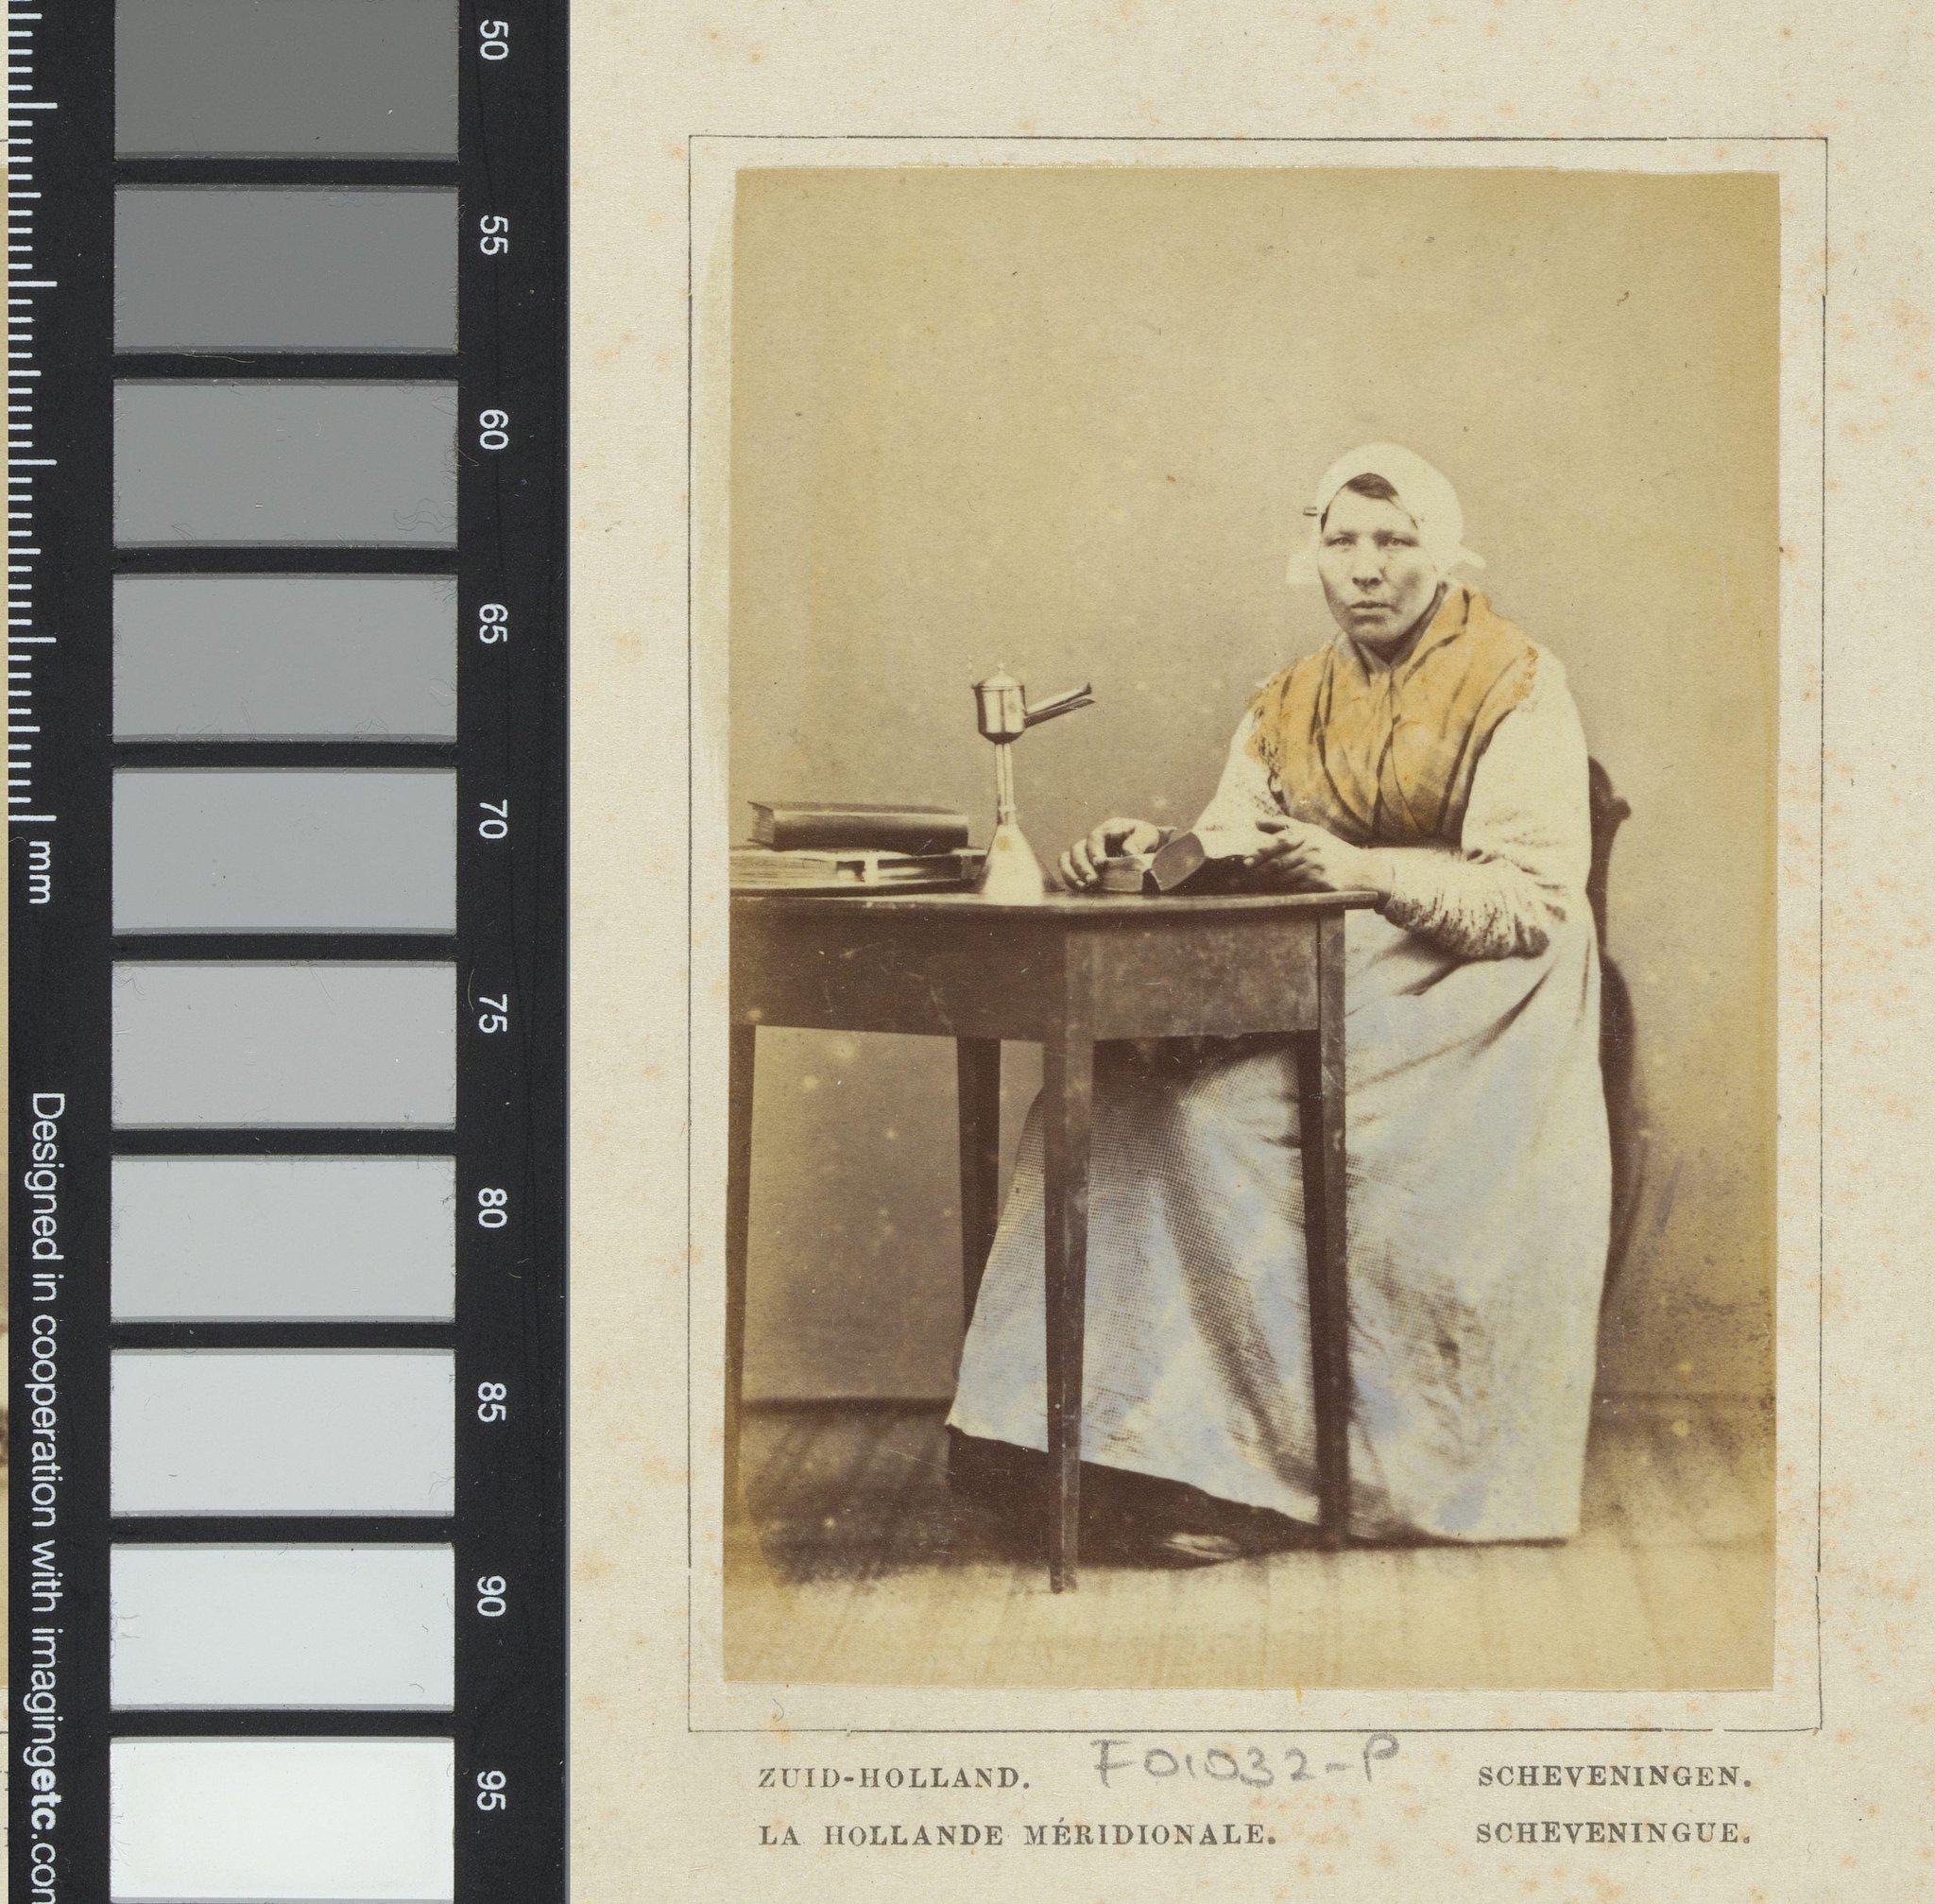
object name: photograph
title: Portret van een onbekende vrouw met fotoalbums of boeken in klederdracht van Scheveningen, Zuid-Holland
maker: andries jager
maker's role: publisher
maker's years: 1825-1905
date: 1860-1890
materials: cardboard, photographic support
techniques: albumen print, hand coloring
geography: amsterdam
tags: folk costume, regional costume (+ women's clothes), historical persons - bb - woman, europeans (with name), netherlands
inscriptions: inscription: ‘Uitgave van A. JAGER, Water 110 te Amsterdam.’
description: Deze foto maakt deel uit van een omslag met 48 foto's op 12 bladen.